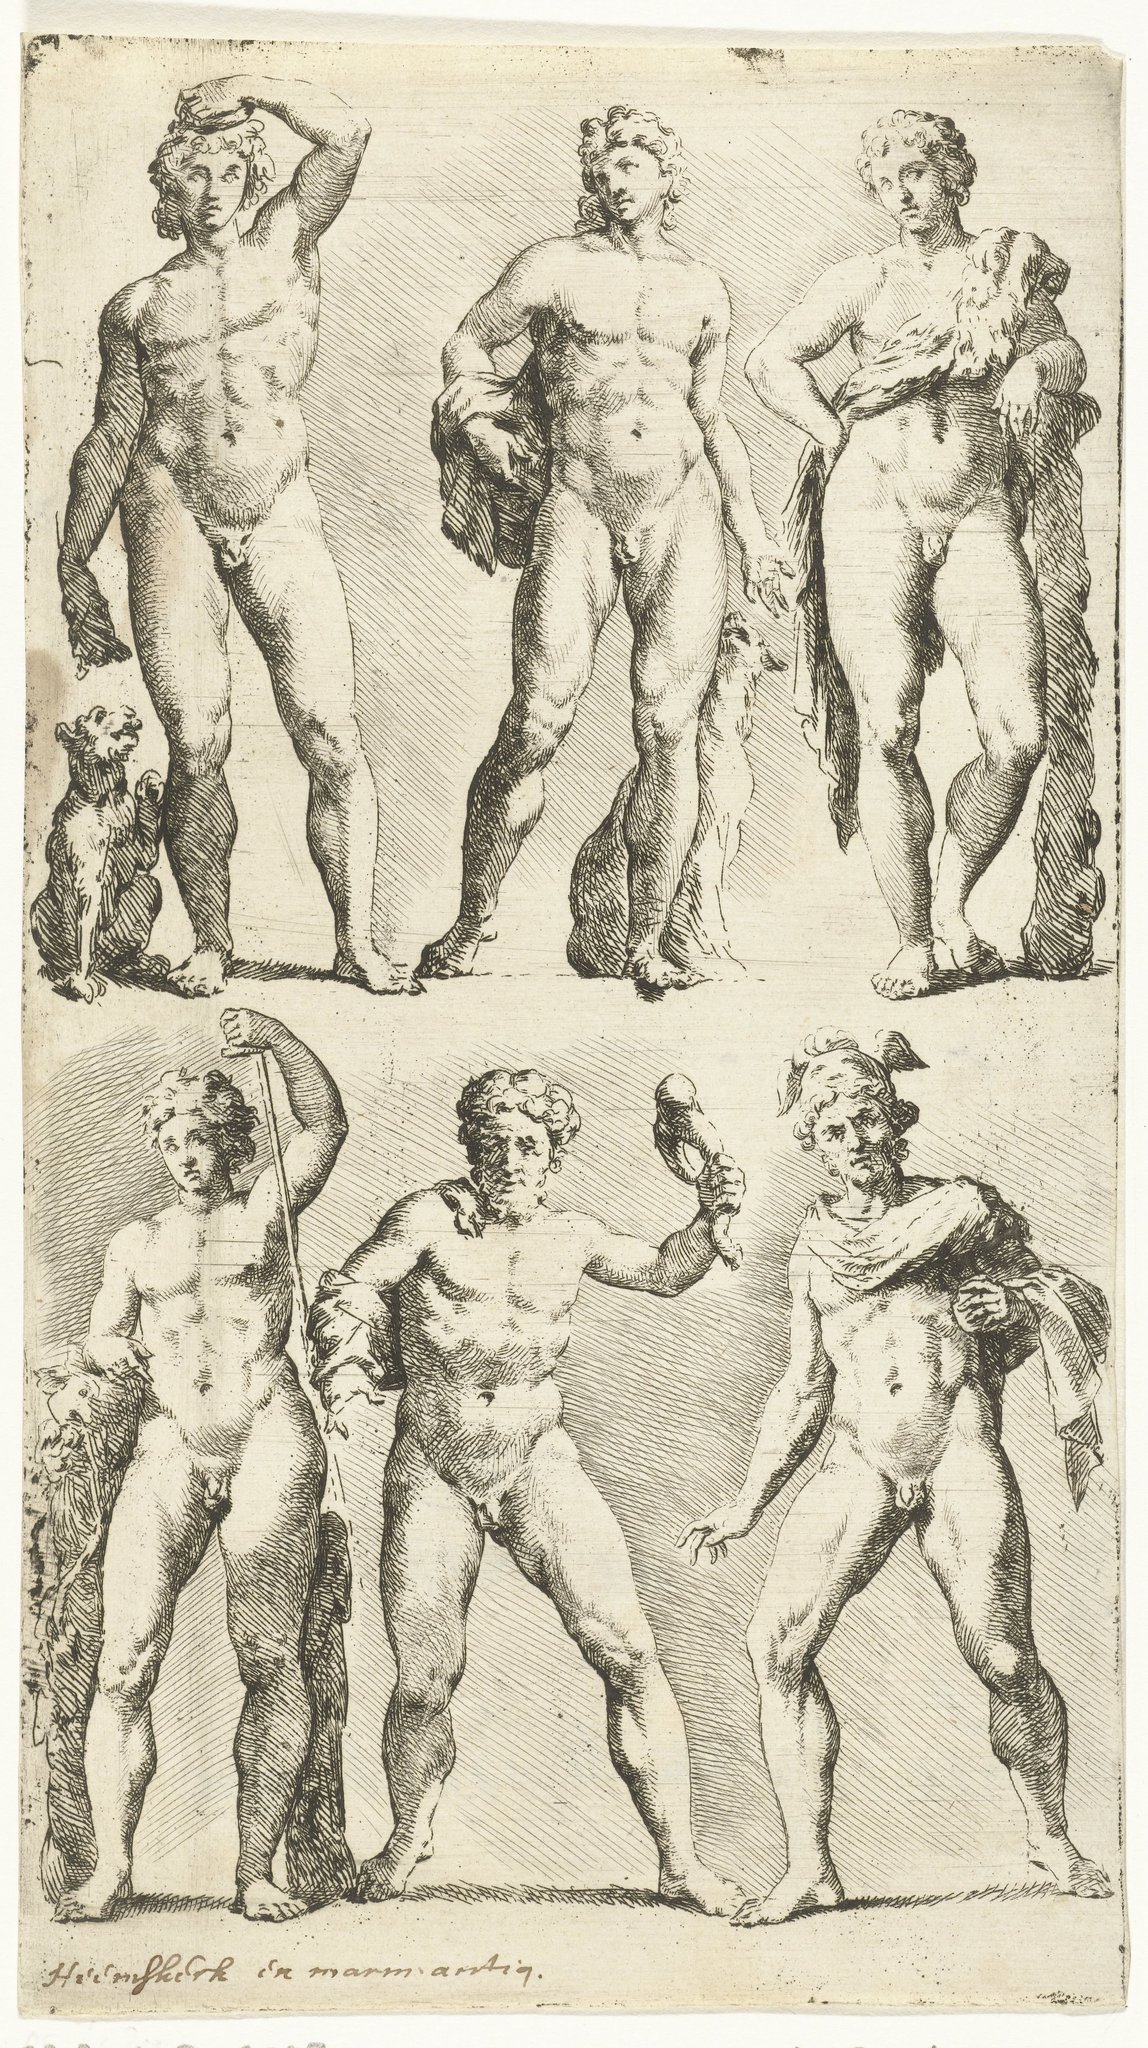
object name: print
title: Zes beelden van mannen met verschillende attributen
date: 1668-1671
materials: paper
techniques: etching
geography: northern netherlands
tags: (story of) bacchus (dionysus), liber, satyr(s) (in general), attributes of orpheus (with name), (story of) orpheus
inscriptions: collector's mark: Lugt 2228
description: Zes antieke beelden van naakte mannen. Boven in het midden Orpheus met zijn hond Cerberus, onder links de god Dionysus. De andere beelden stellen waarschijnlijk saters voor.